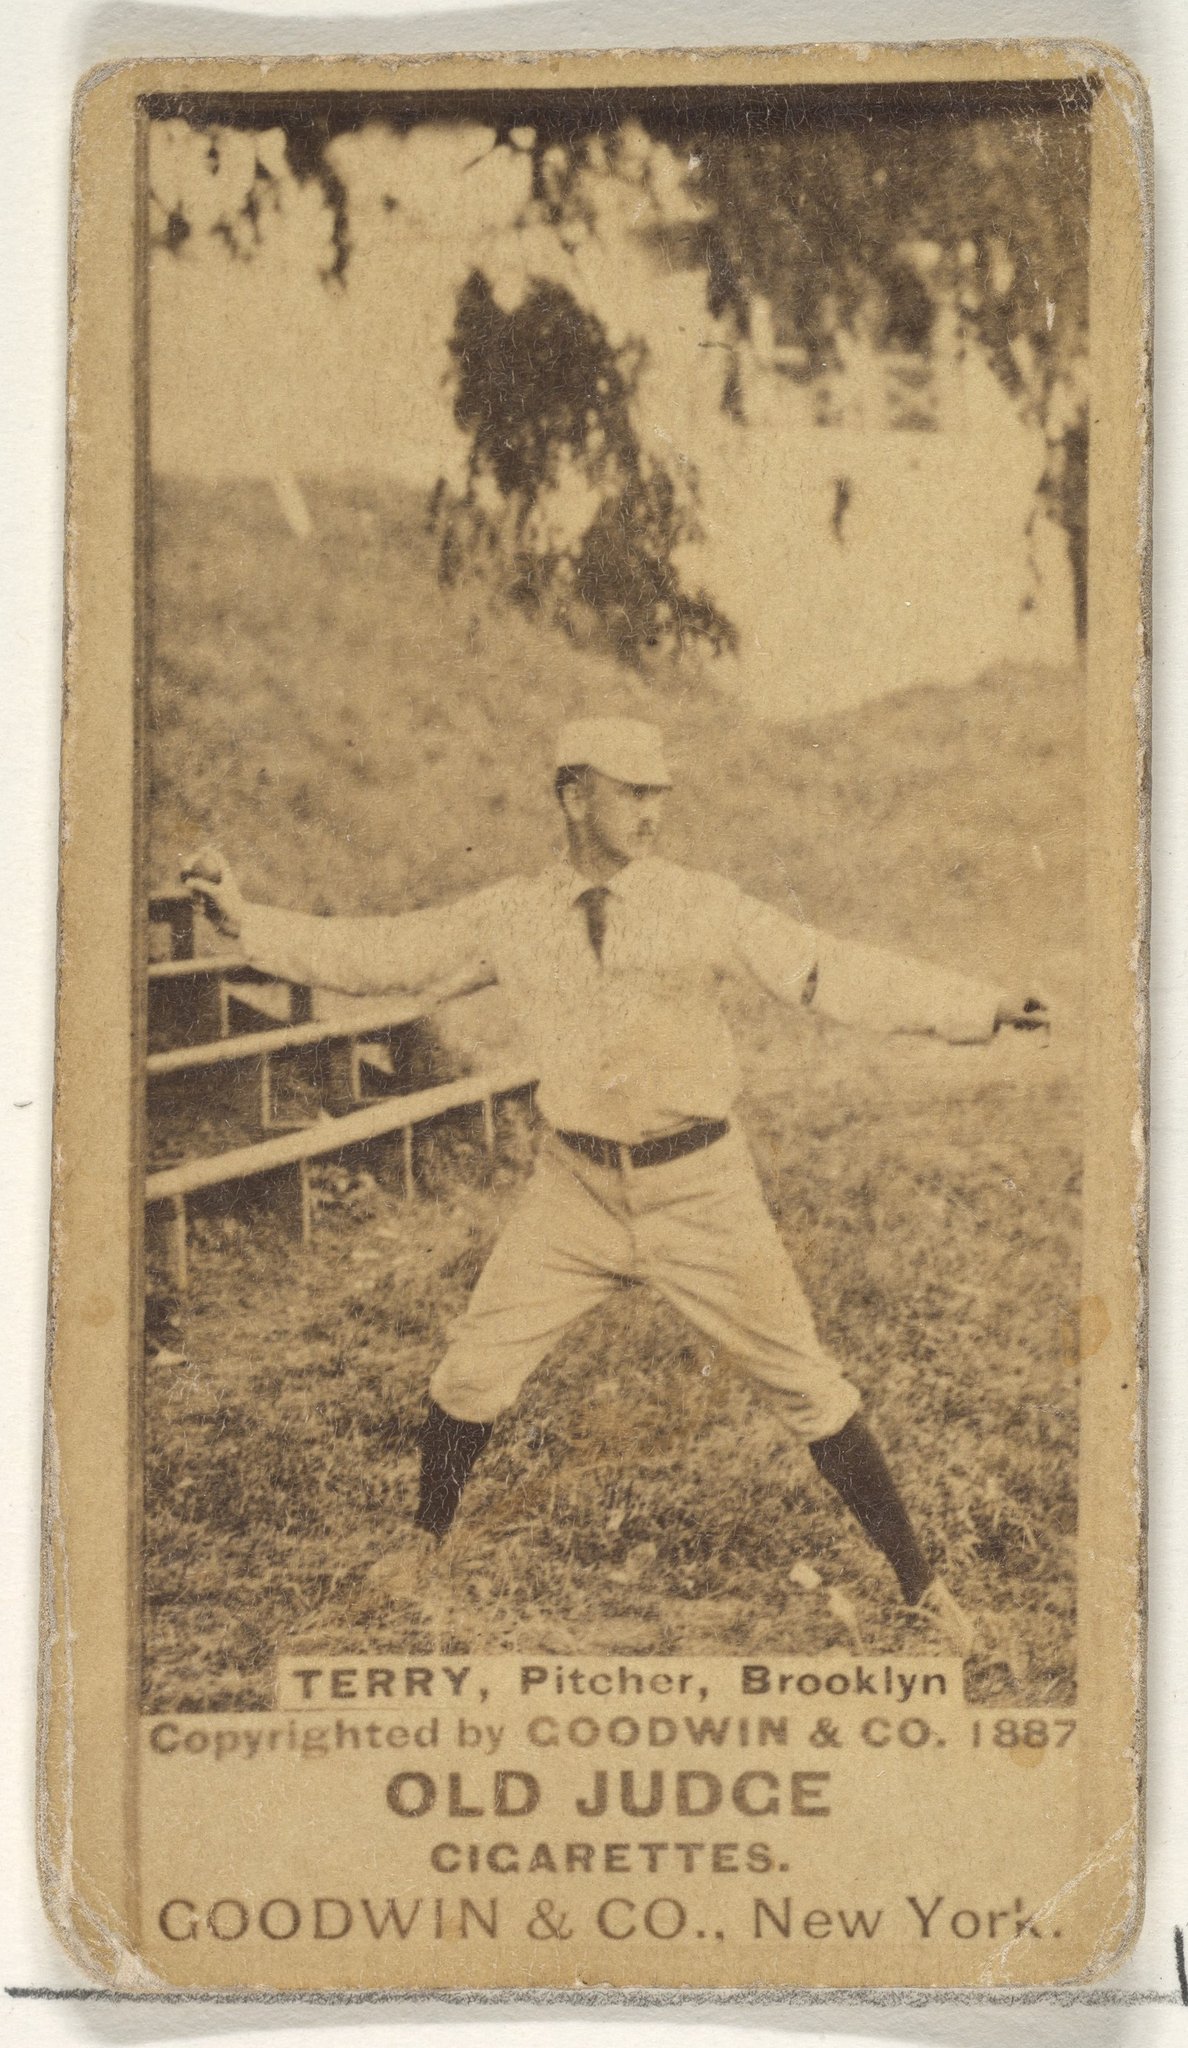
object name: baseball card, photograph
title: Terry, Pitcher, Brooklyn, from the Old Judge series (N172) for Old Judge Cigarettes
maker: goodwin & company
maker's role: publisher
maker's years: 1850-1950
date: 1887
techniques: albumen silver print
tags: men,portraits,baseball,athletes